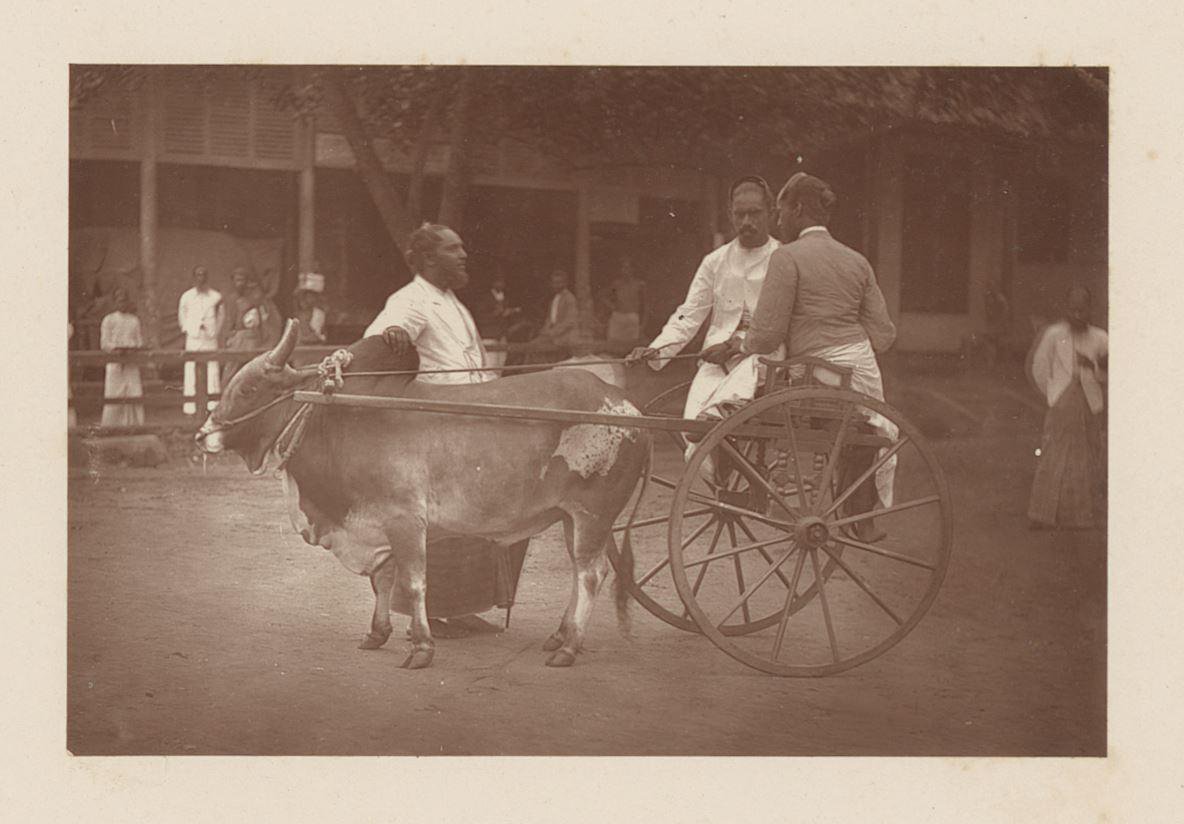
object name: photograph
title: Men and bullock cart in Colombo, Sri Lanka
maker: Anonymous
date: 1880-1883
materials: photographic support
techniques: albumen print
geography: colombo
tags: two-wheeled, animal-drawn vehicle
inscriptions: inscription: ‘Columbo _ (Ceylon) _’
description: Onderdeel van Reisalbum met opnames van bezienswaardigheden in Egypte, Nederlands-Indië, Singapore en Ceylon.